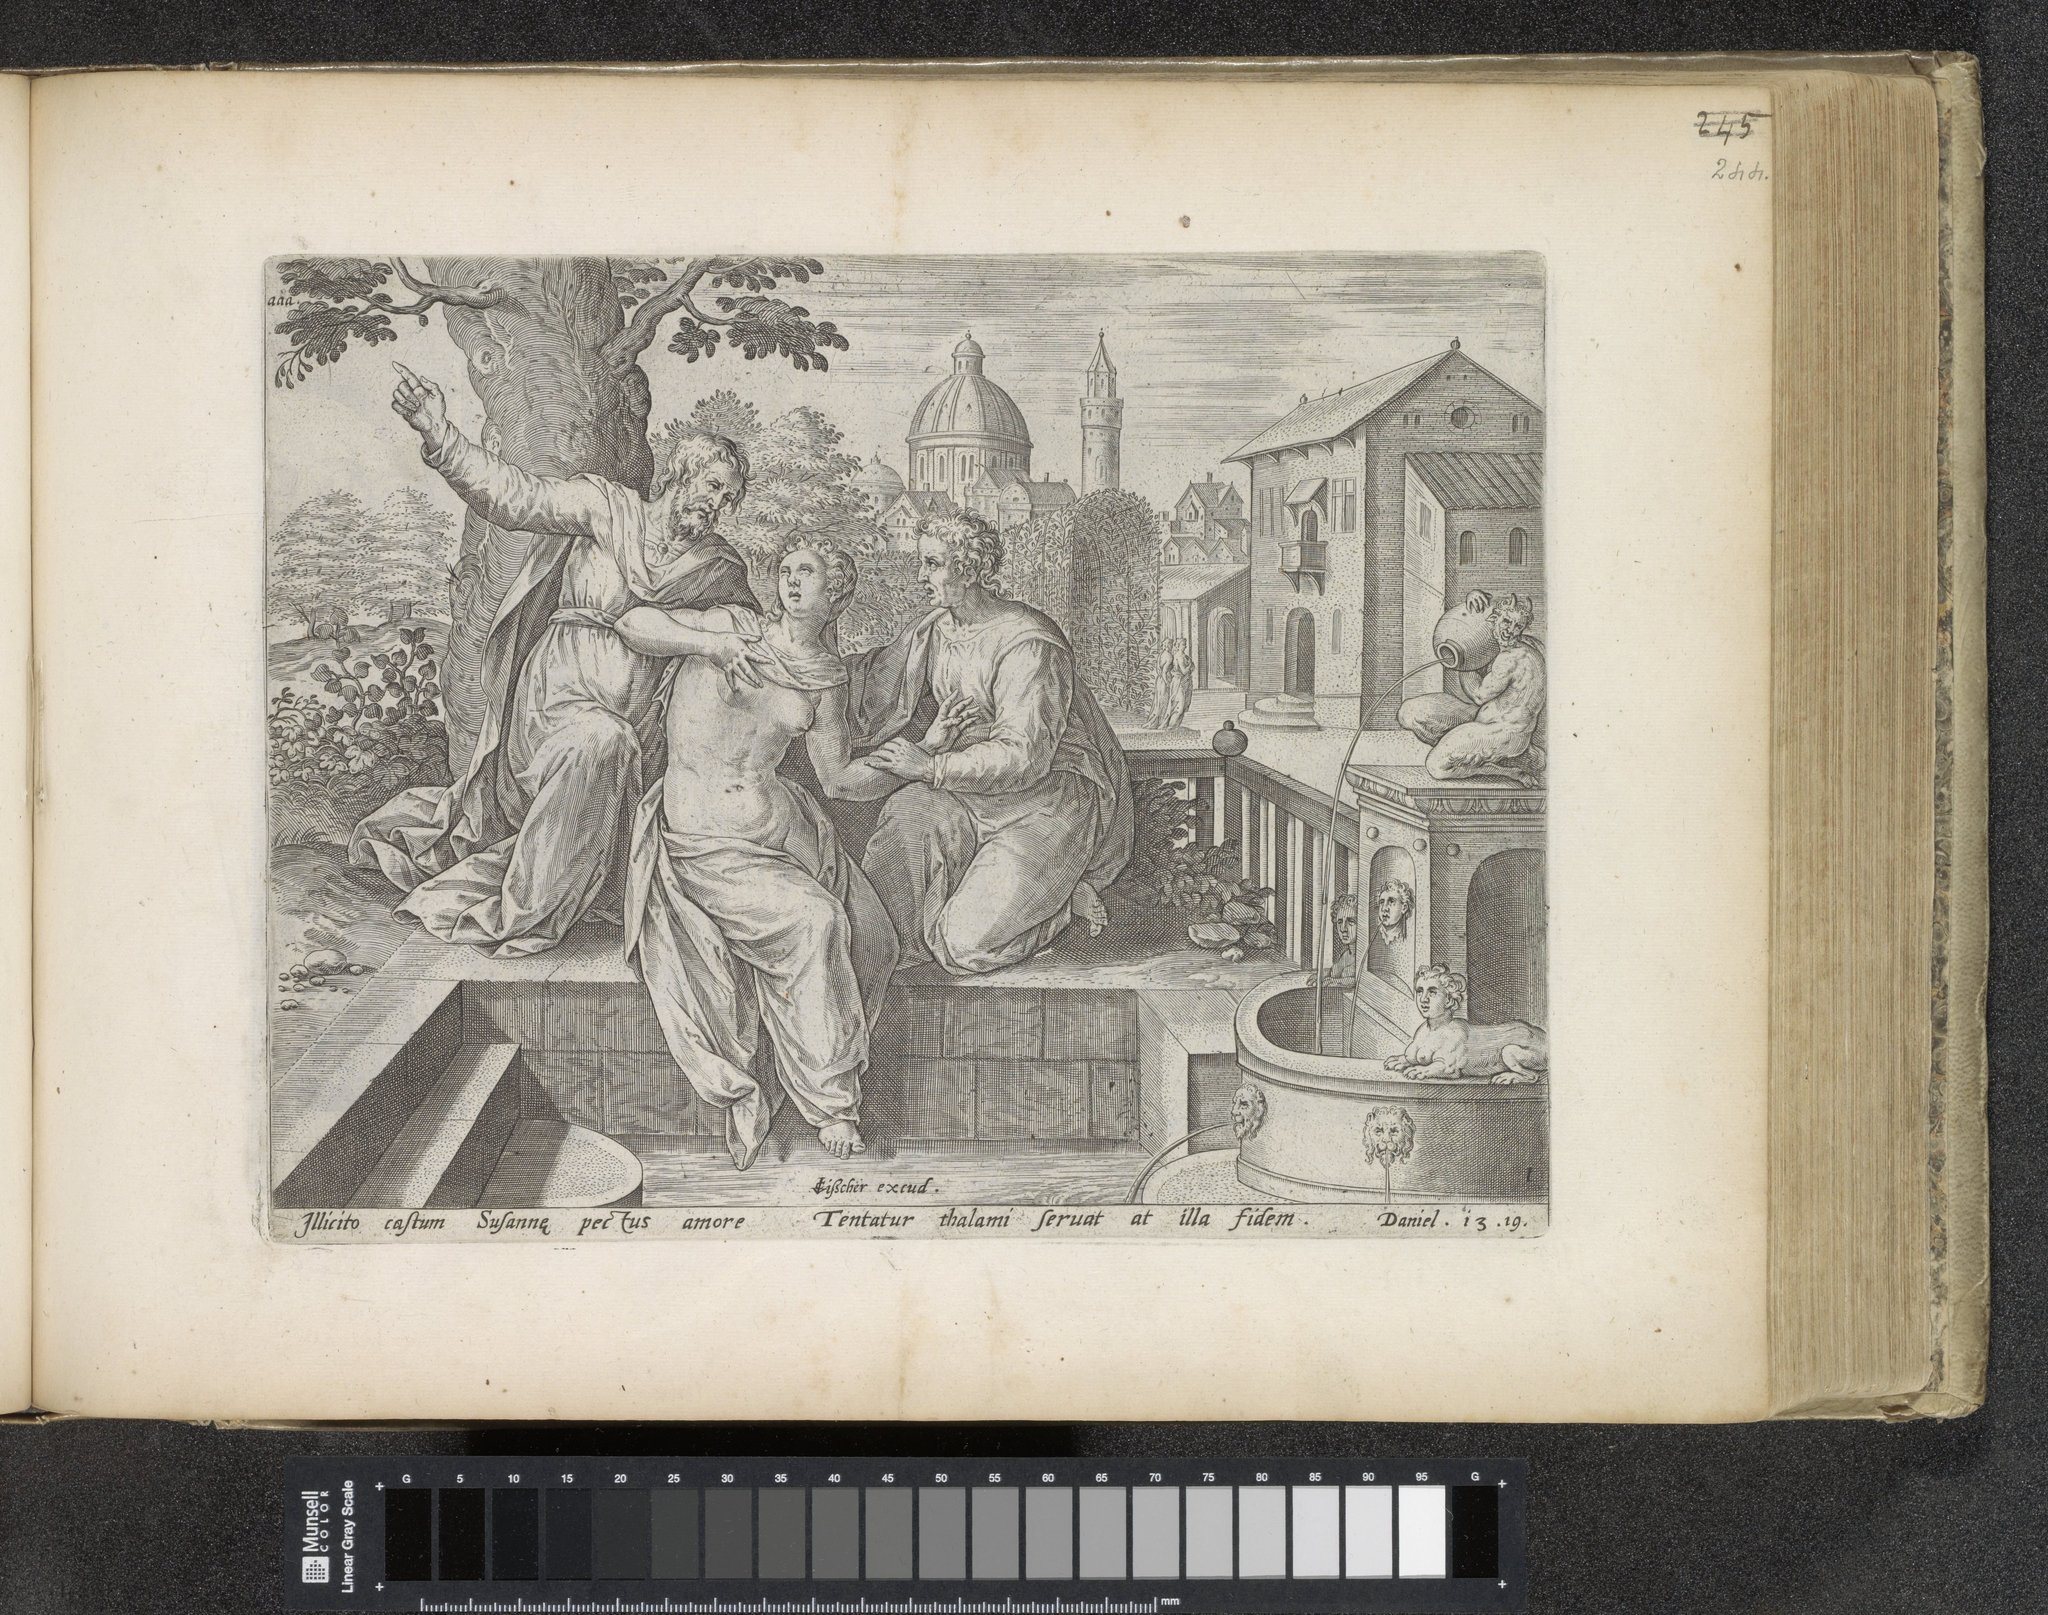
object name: print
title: Theatrum Biblicum Hoc Est Historiae Sacrae Veteris et Novi Testamenti Tabulis Aeneis Expressae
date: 1579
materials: paper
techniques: engraving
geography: amsterdam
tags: the elders making advances towards susanna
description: Susanna, die op de rand van een bassin zit om zich te baden, wordt lastig gevallen door de twee oudsten. Onder de voorstelling een verwijzing in het Latijn naar de Bijbeltekst in Dan. 13:19. Deze prent maakt deel uit van een album.